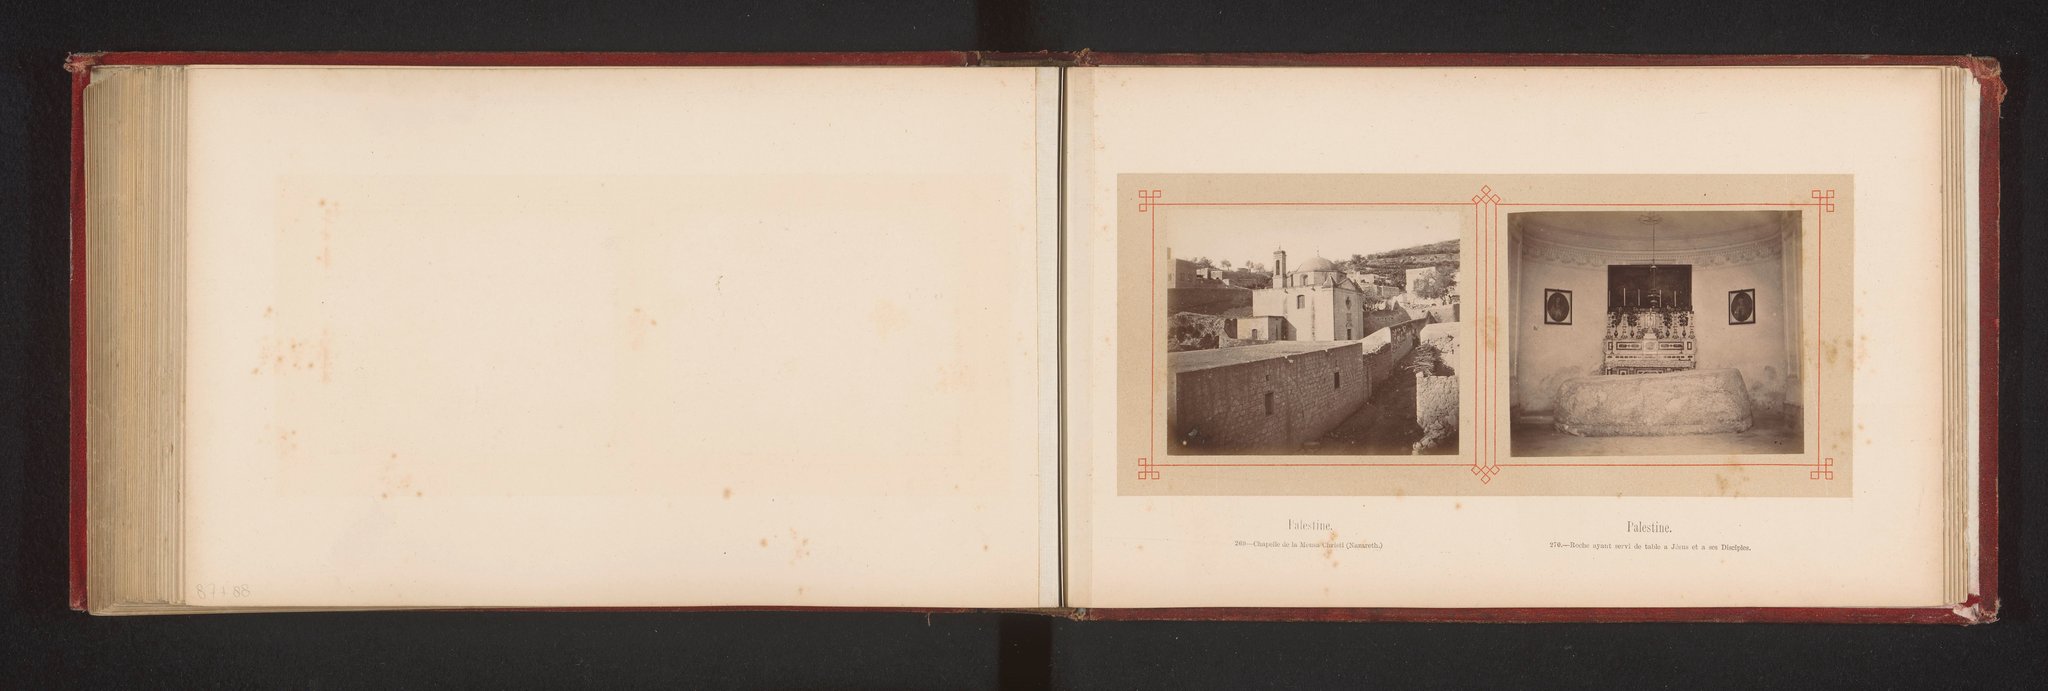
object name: page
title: Palestine - 270 - Roche ayant servi de table a Jésus et ses Disciples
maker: félix bonfils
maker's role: fotograaf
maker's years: 1831-1885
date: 1873-1878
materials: photographic support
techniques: albumen print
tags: parts of church interior: chapel